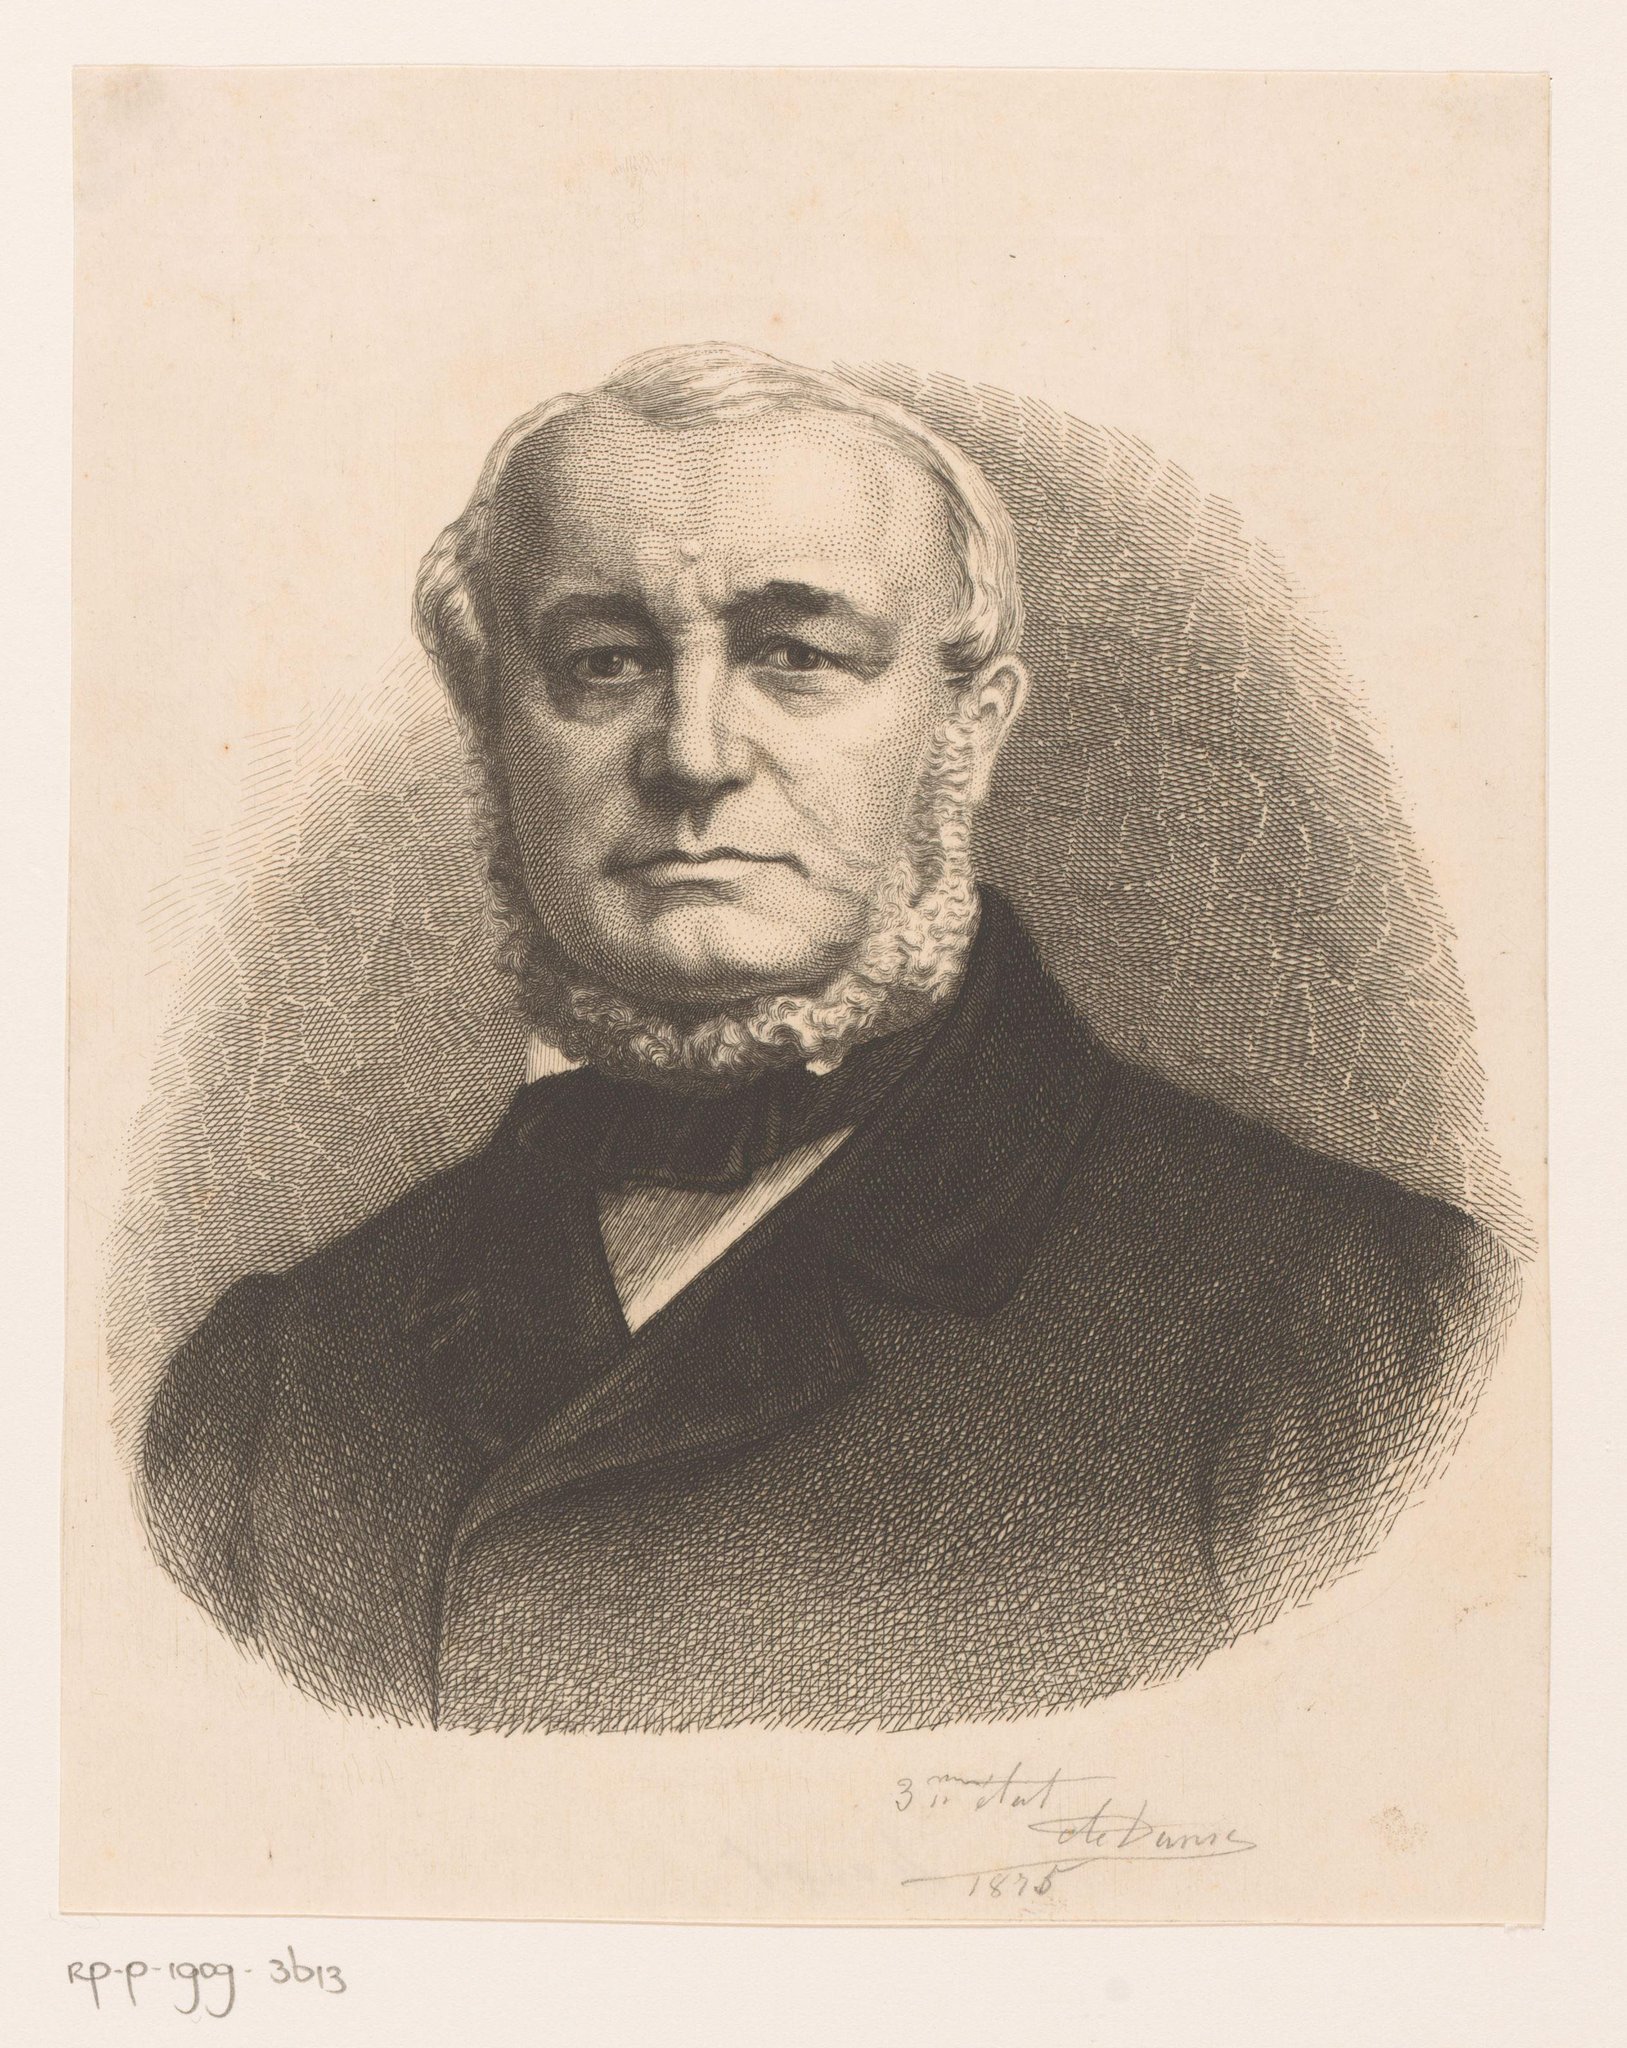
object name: print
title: Portret van een onbekende man genaamd Raymaekers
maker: auguste danse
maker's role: print maker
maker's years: 1829-1929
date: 1883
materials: paper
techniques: etching, intaglio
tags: anonymous historical person portrayed alone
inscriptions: collector's mark: Lugt 2228, annotation: ‘Raymaekers’, annotation: ‘3ème état’